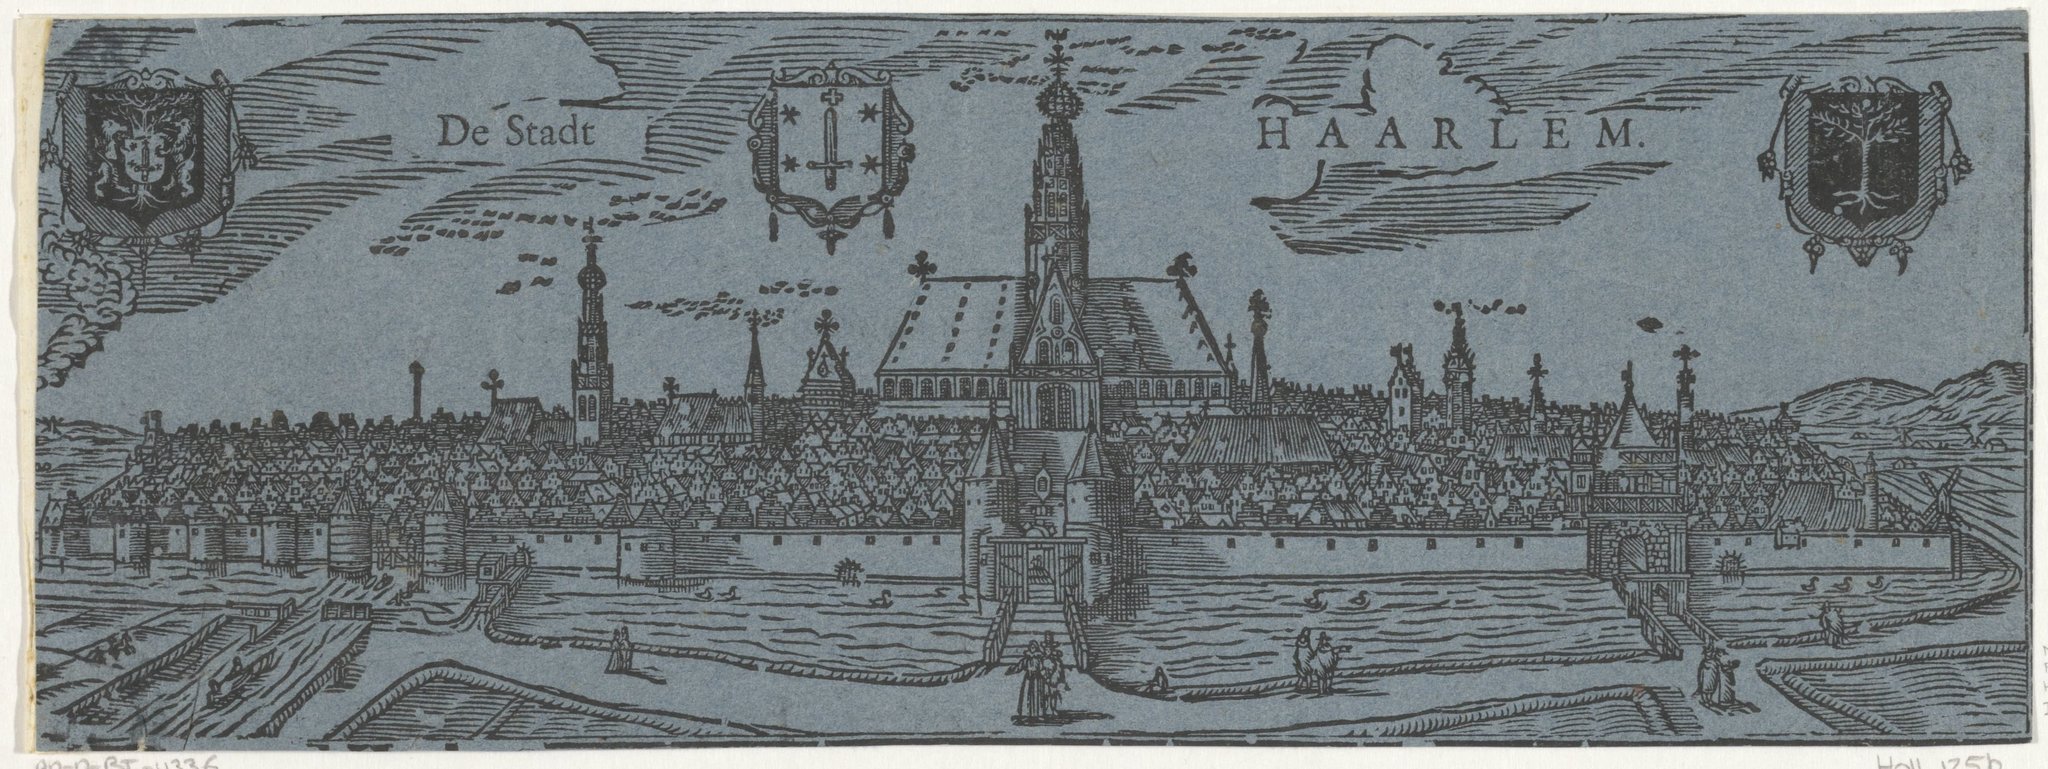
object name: print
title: Gezicht op de stad Haarlem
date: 1600-1699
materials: paper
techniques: woodcut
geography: netherlands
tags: prospect of city, town panorama, silhouette of city, haarlem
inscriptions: collector's mark: Lugt 2228